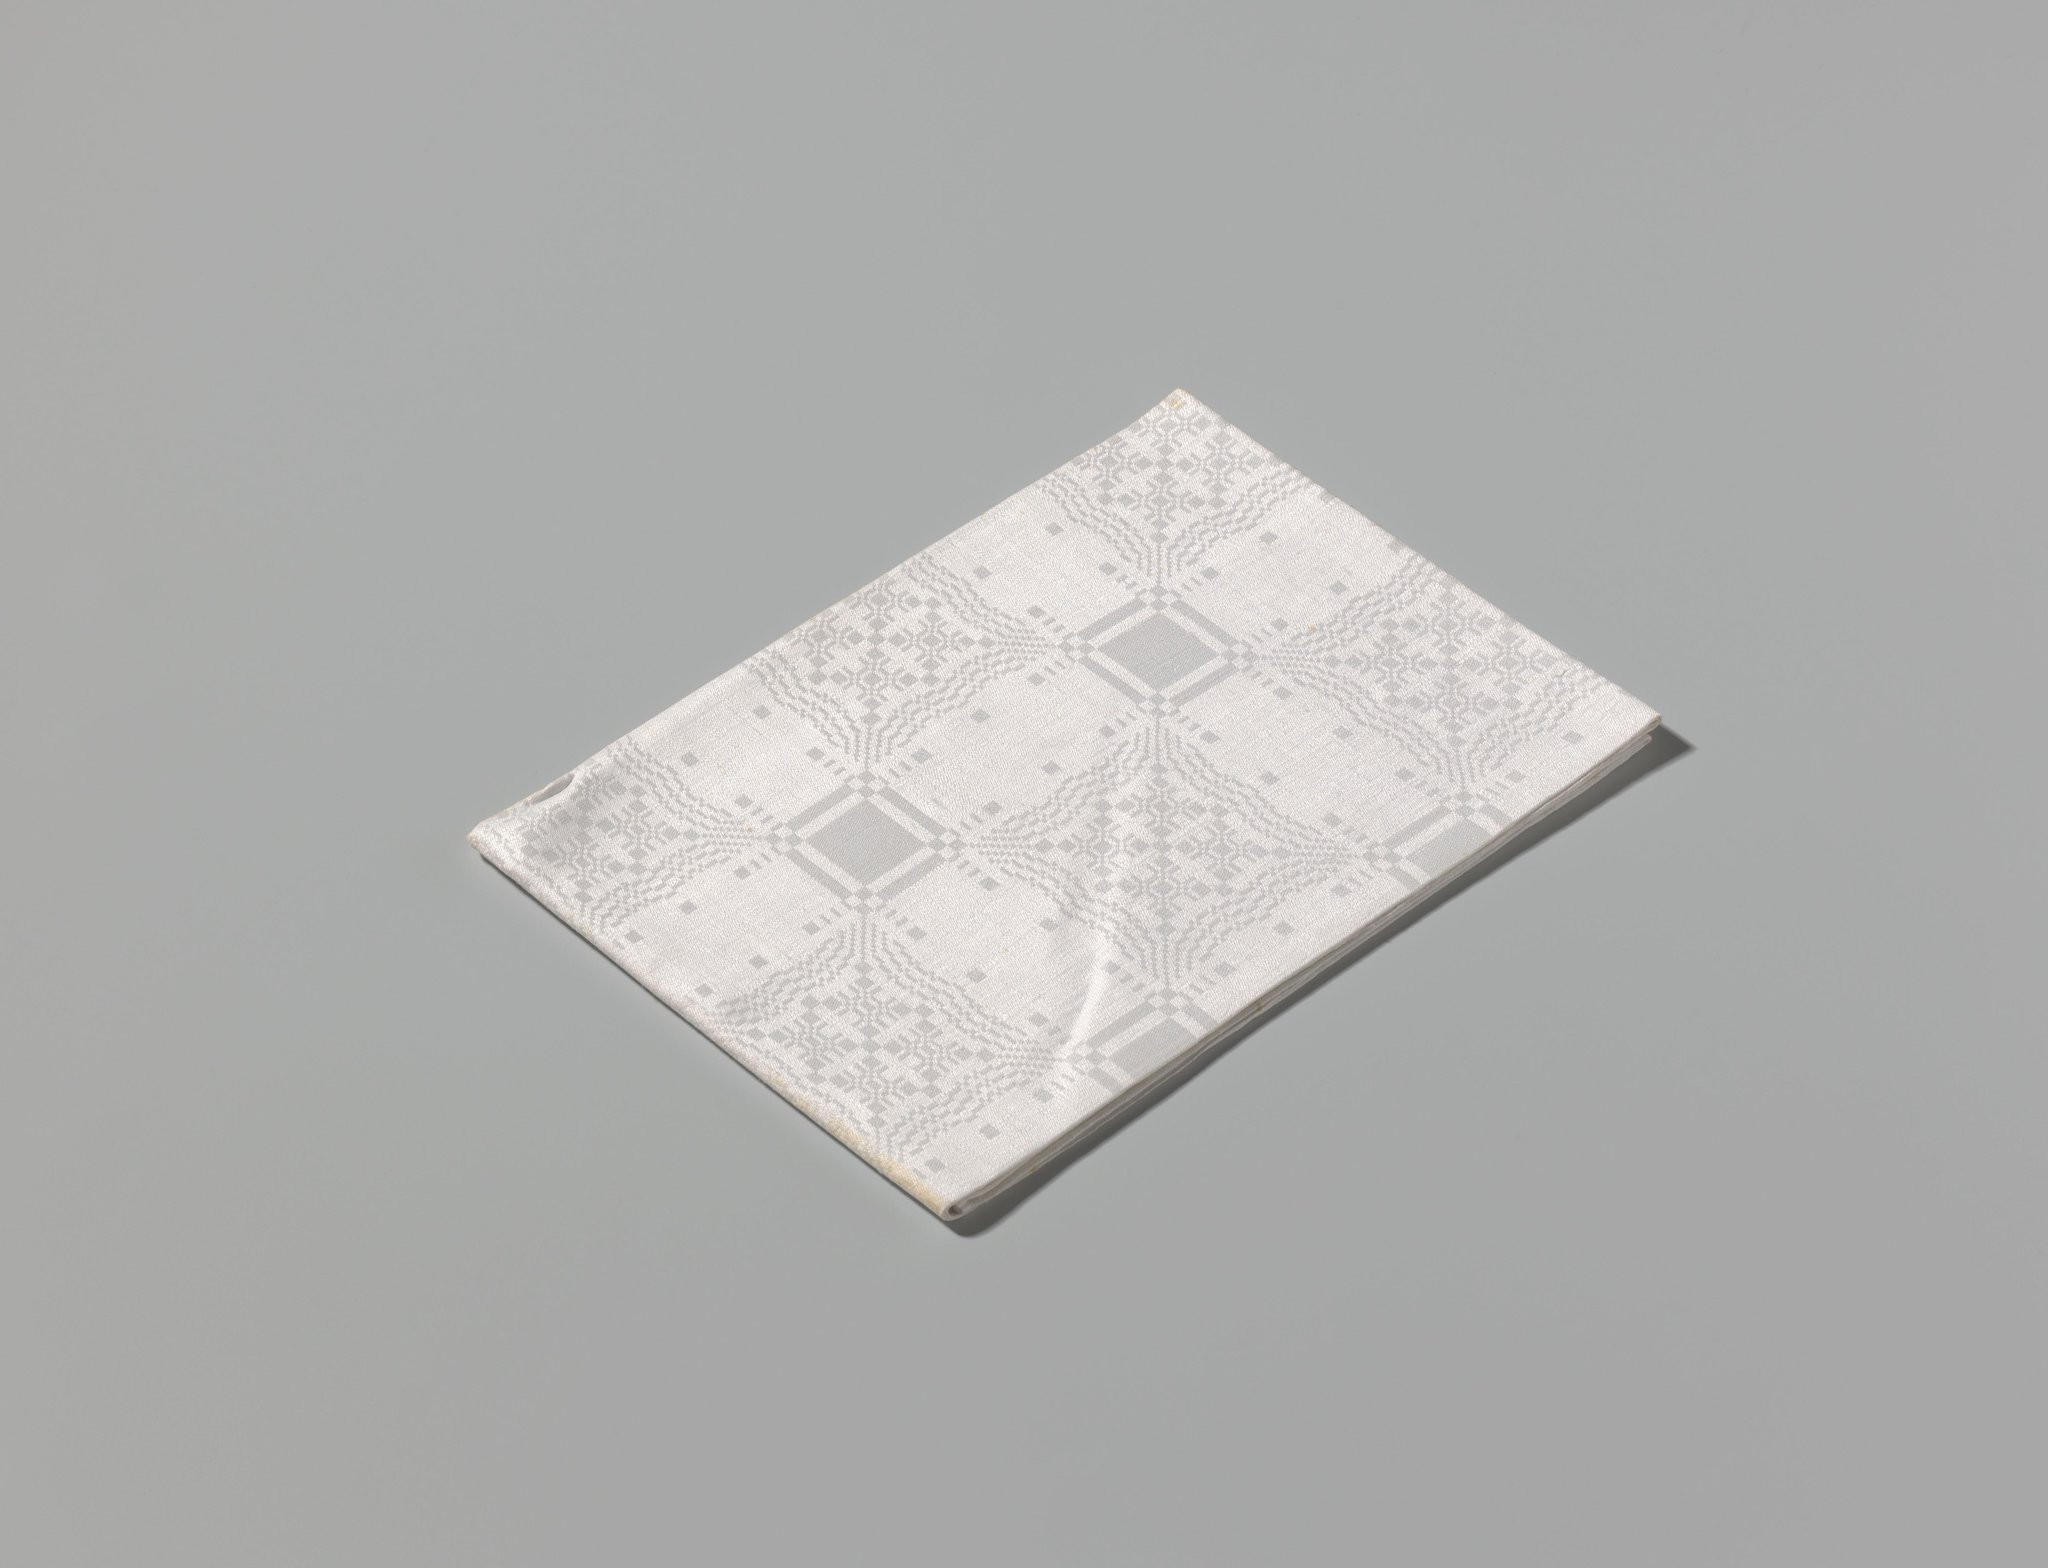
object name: napkin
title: Servet van linnen met pellenpatroon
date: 1734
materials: linen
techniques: peeled fabric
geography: northern netherlands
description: wit linnen servet met pellen patroon, merk AVG 38 en 1734